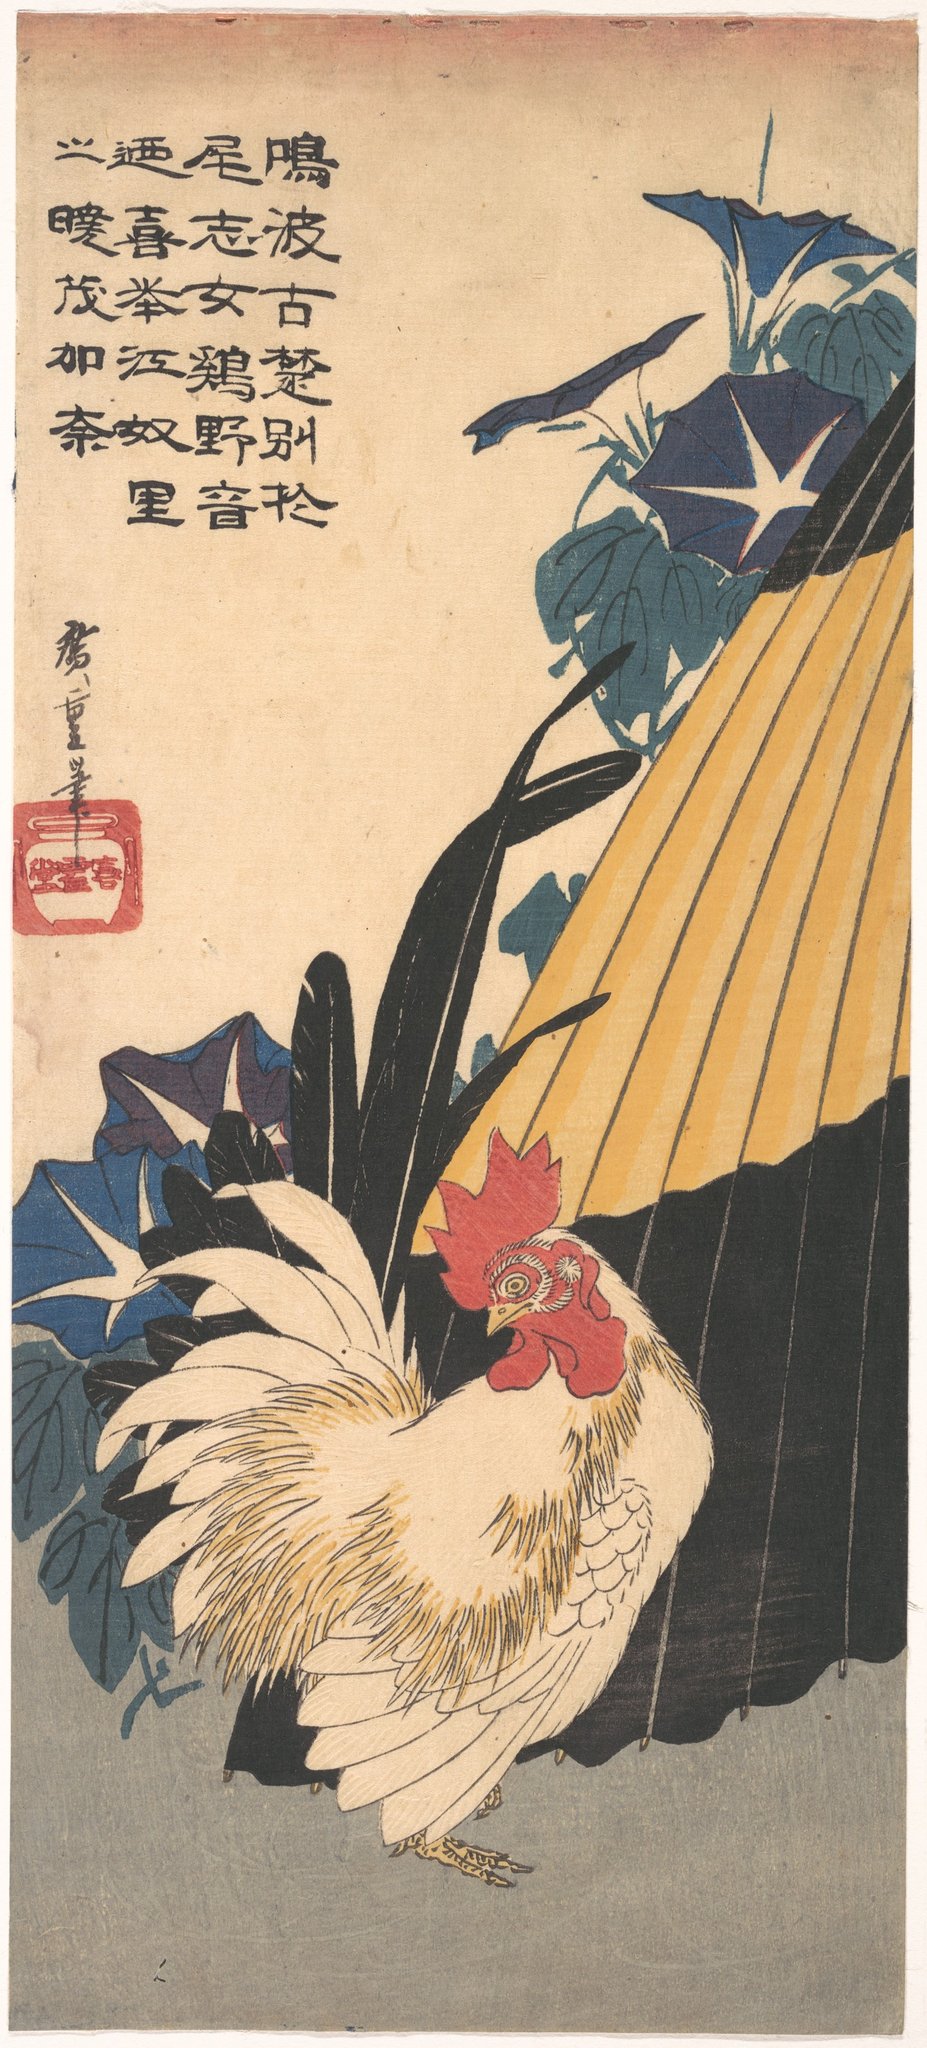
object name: print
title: Rooster, Umbrella, and Morning Glories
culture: japanese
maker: utagawa hiroshige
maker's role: artist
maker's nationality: japanese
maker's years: 1797-1858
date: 1830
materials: ink, paper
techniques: woodblock print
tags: roosters,flowers